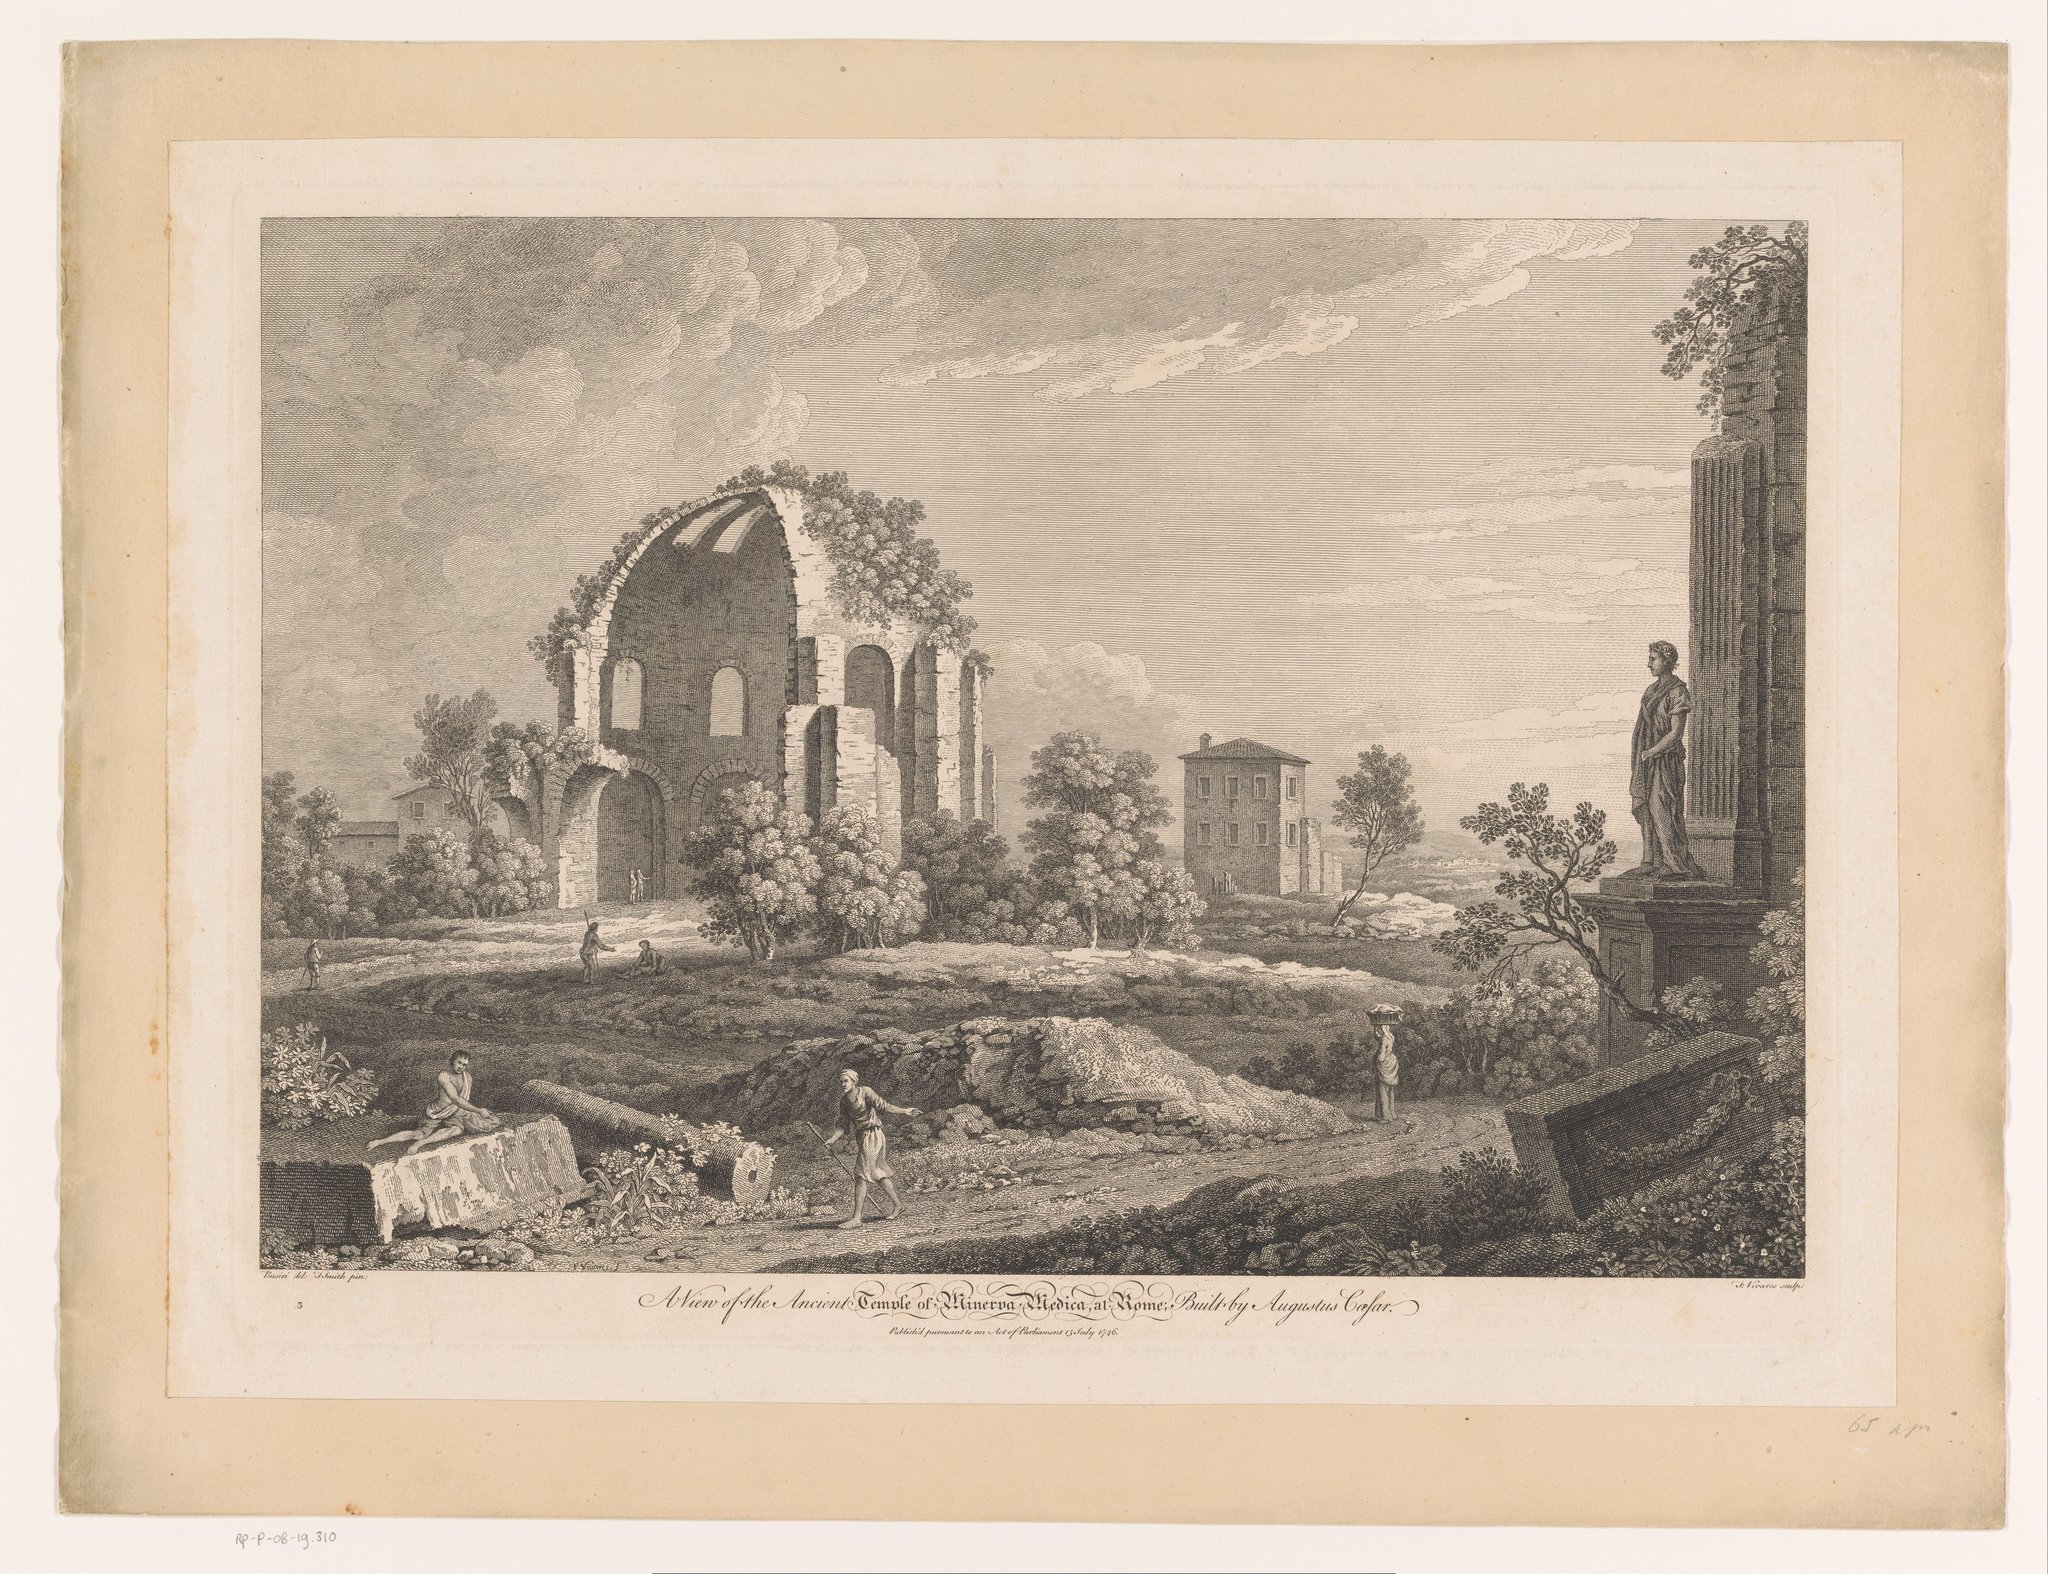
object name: print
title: Gezicht op de zogenaamde Tempel van Minerva Medica te Rome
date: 1707-1746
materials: paper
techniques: etching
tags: (story of) minerva (pallas, athena), landscape with ruins (+ city(-scape) with figures, staffage)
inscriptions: collector's mark: Lugt 2228